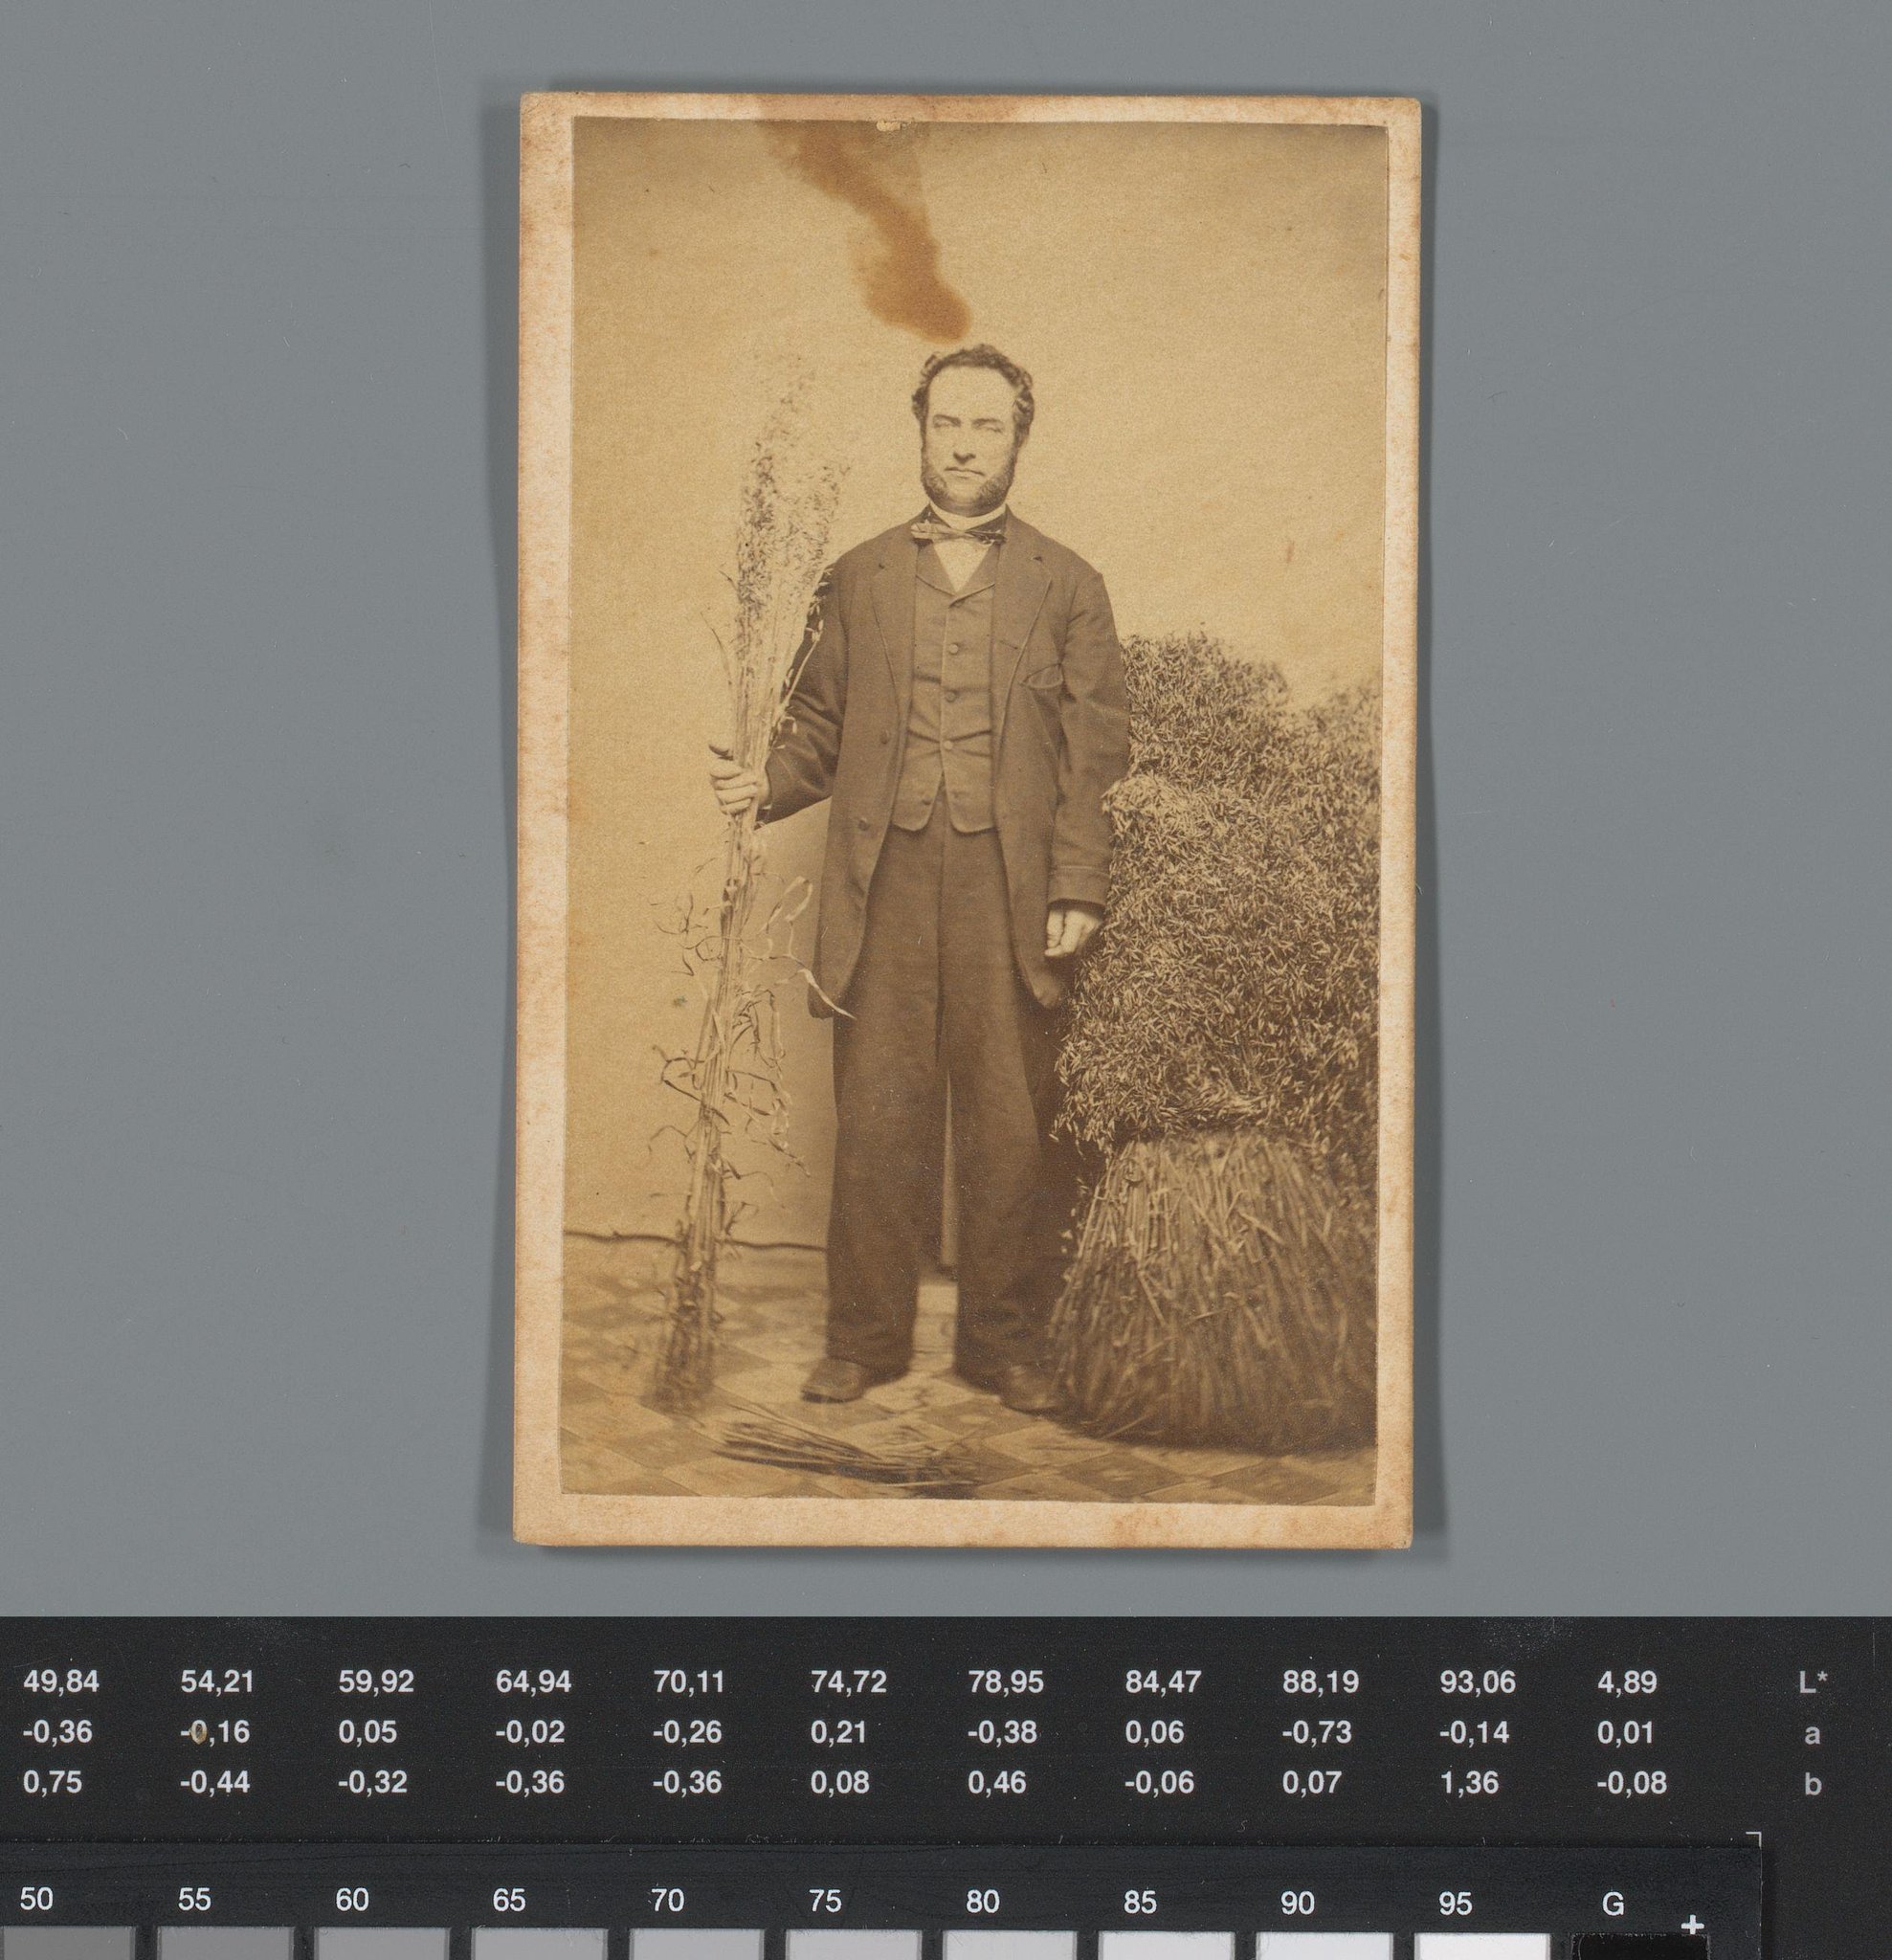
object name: photograph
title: Reclame voor een nieuwe soort haver met portret van een onbekende man met een haverplant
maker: Anonymous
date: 1850-1915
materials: cardboard, photographic support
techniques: albumen print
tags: advertising, cereal, grain, corn (grass with grains, grown for food, e.g.: wheat, rice, rye, oats, maize, buckwheat, millet), historical persons not known by name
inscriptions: inscription: ‘"SURPRISE OATS" / These oats are an entirely new variety, (...) Brooklyn, N.Y.’